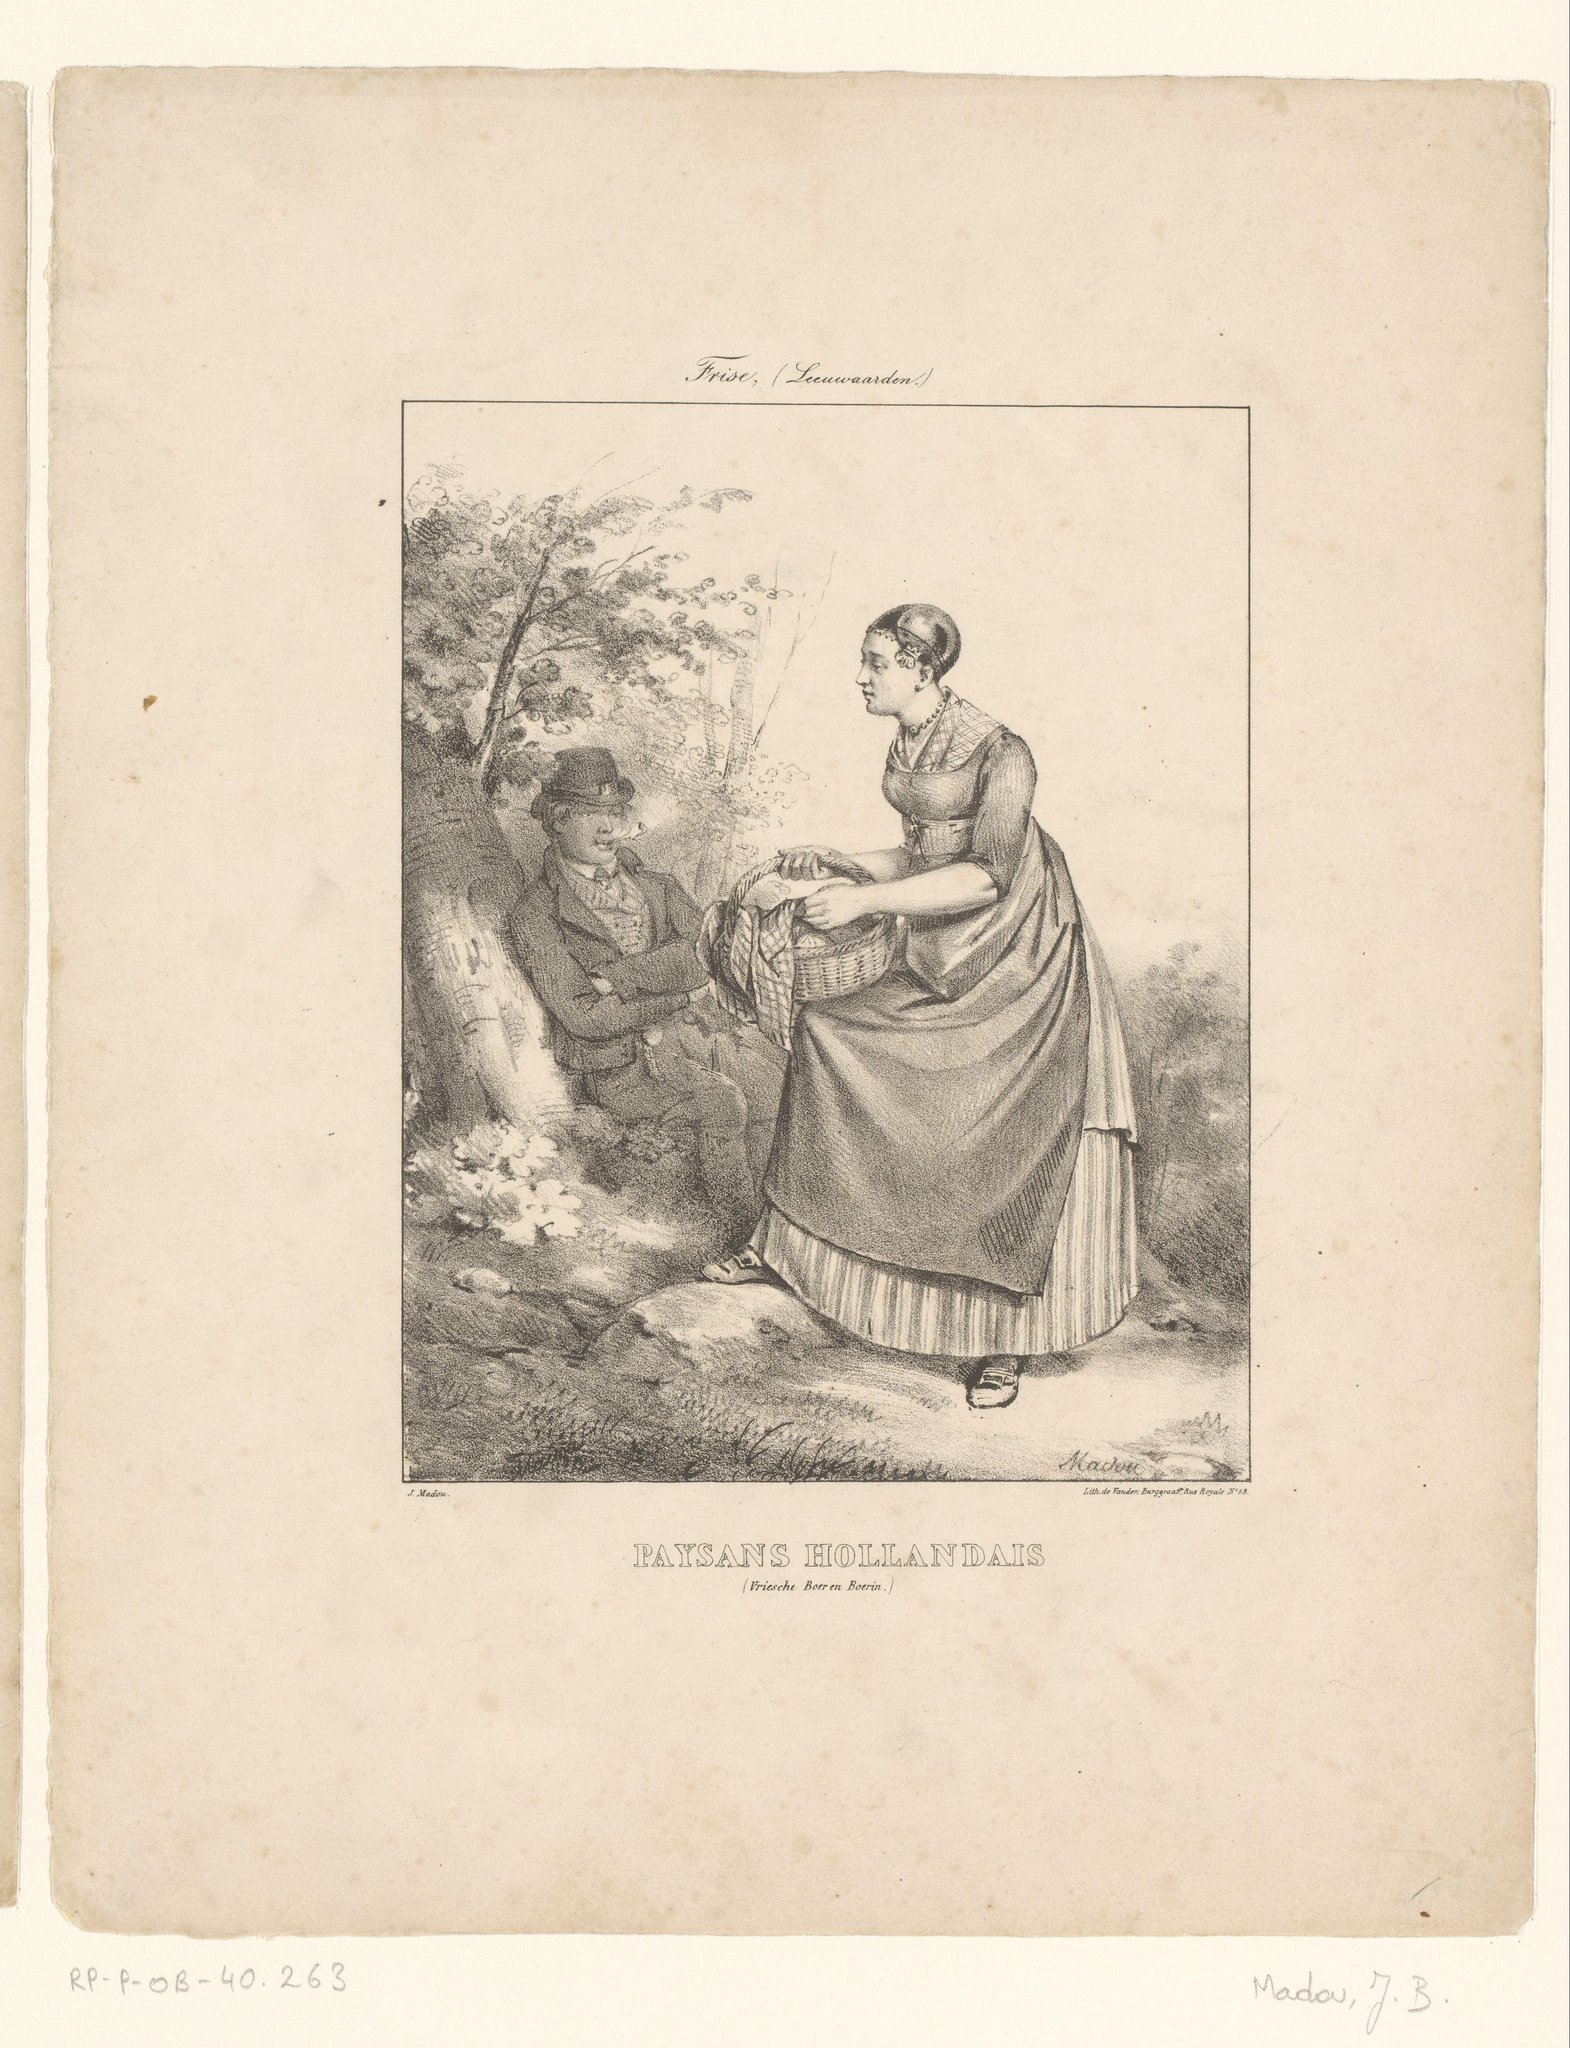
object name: print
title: Paysans Hollandais (Vriesche boer en boerin)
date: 1825-1835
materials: paper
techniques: lithograph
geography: brussels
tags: wooden container: barrel, cask, bucket, pipe ~ tobacco, folk costume, regional costume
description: Van den Burggraaff wilde een serie (twintig afleveringen met telkens vier platen) uitgeven met kostuums uit alle provincies van Nederland en België onder de titel 'Costumes du peuple de toutes les provinces des Pays-Bas'. Hij begint met deze serie in 1825 en eindigt hiermee bij de dertiende aflevering in 1830. Omdat in 1830 België zicht afsplitst van Nederland geeft hij de prenten daarna apart uit onder de titels 'Costumes de peuple Hollandais' en 'Collection de costumes du peuple des provinces de la Belgique' (1835).